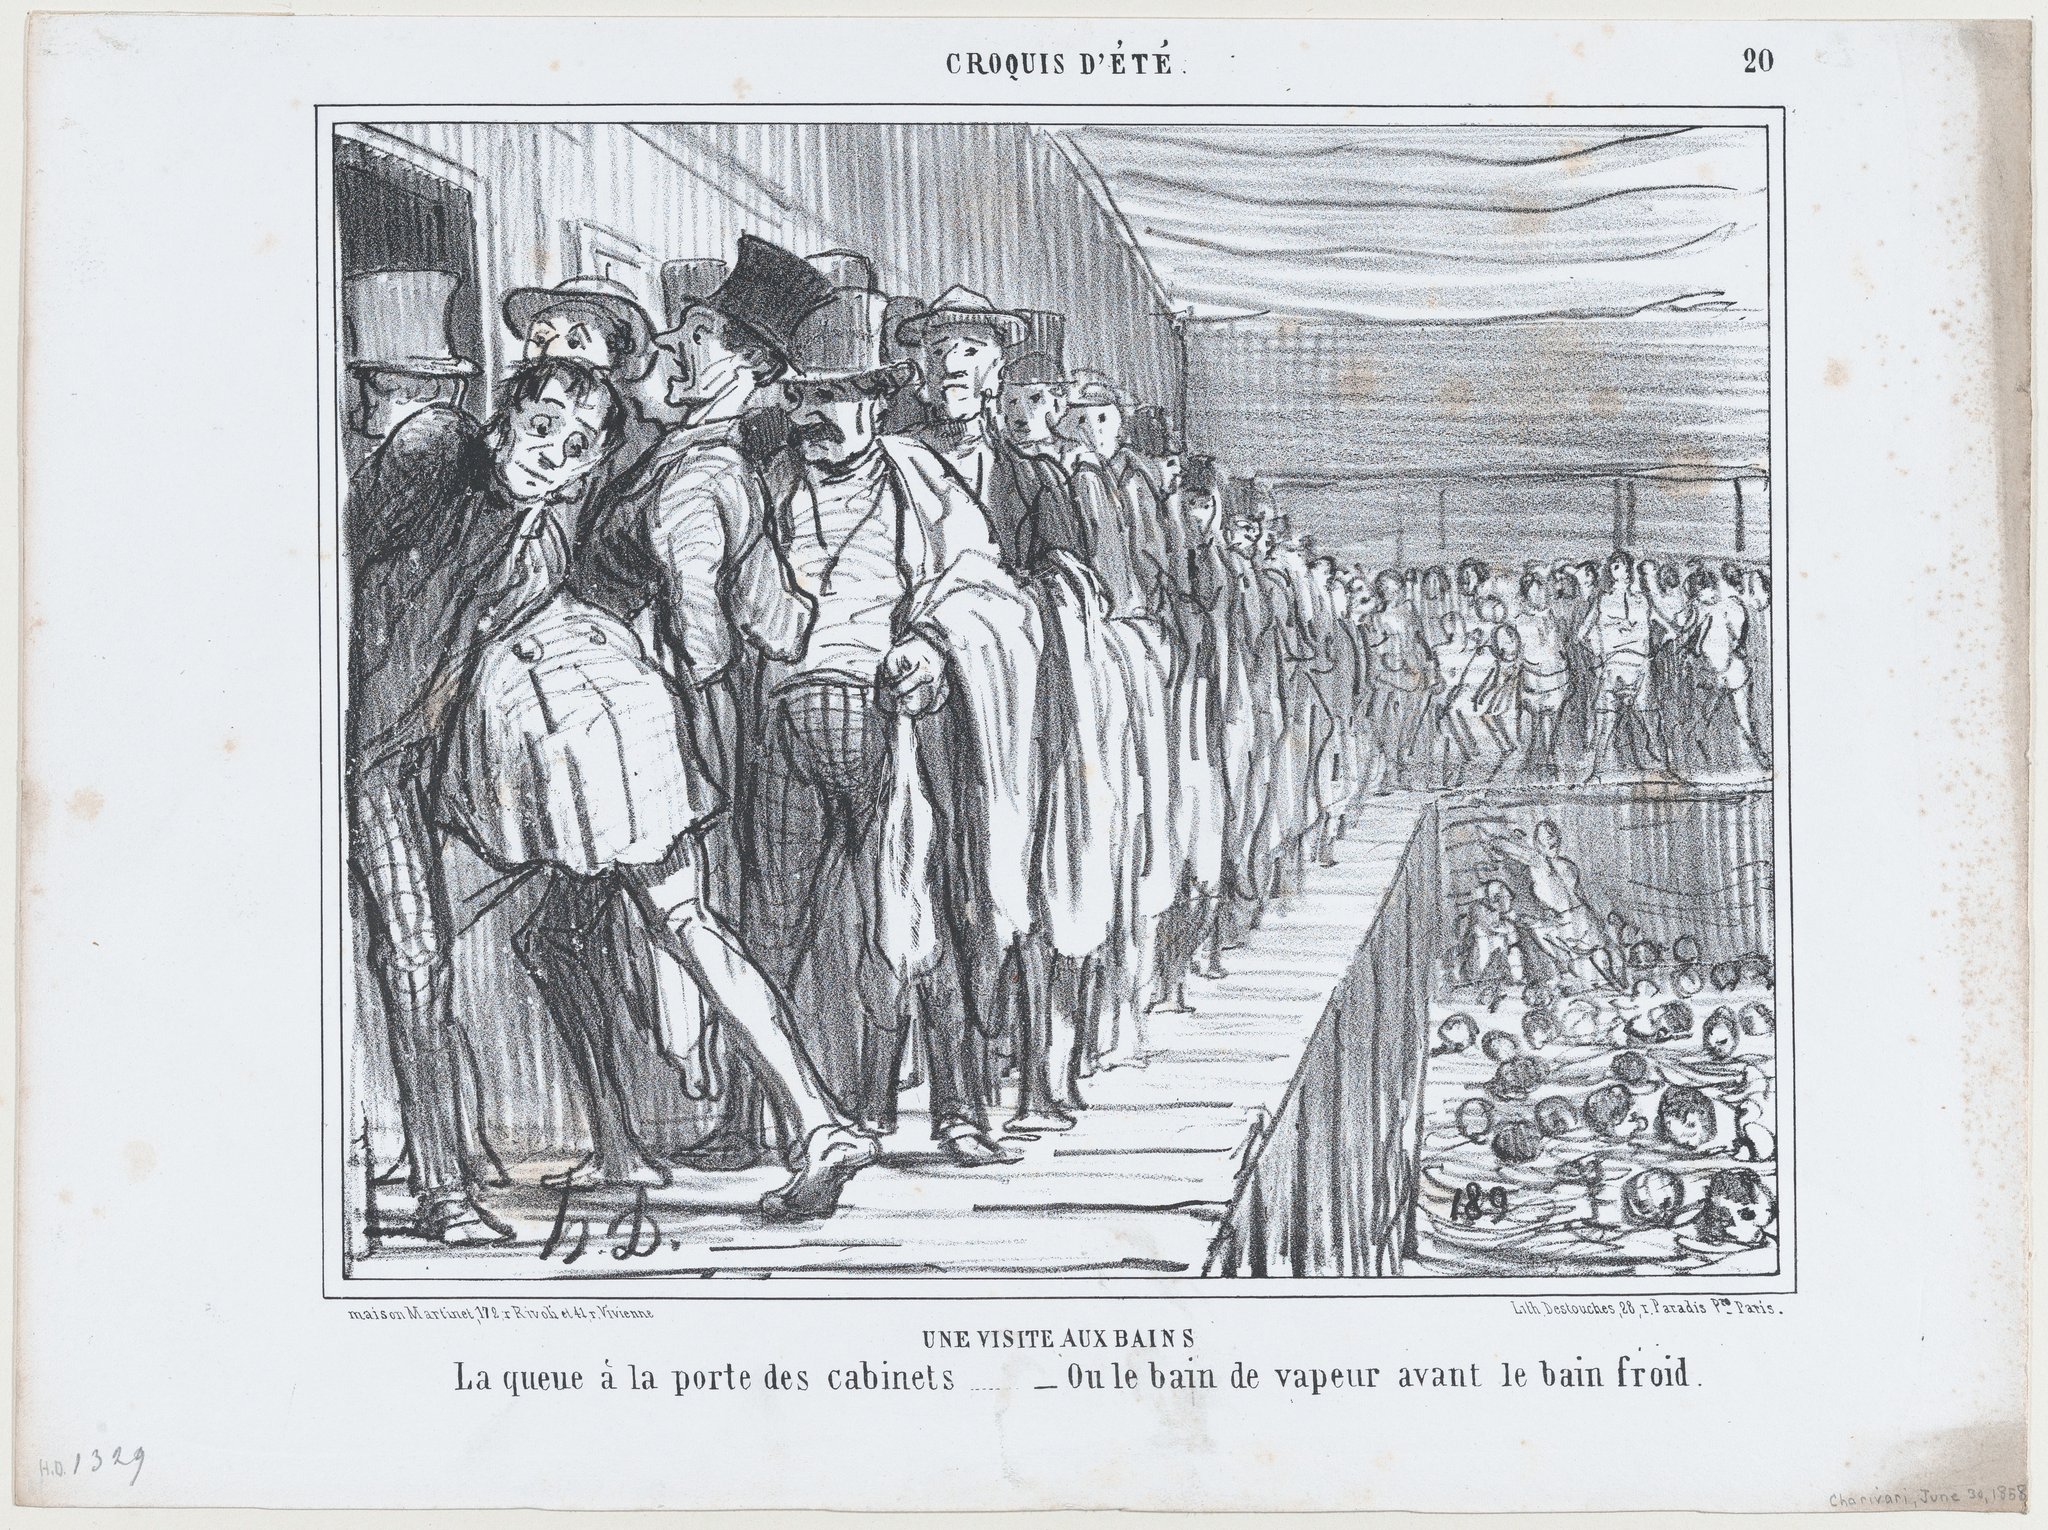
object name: print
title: Une visite aux bains, from Croquis d'Été, published in Le Charivari, June 30, 1858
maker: honoré daumier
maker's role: artist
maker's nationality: french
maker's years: 1808-1879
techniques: lithograph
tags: crowd,bathing